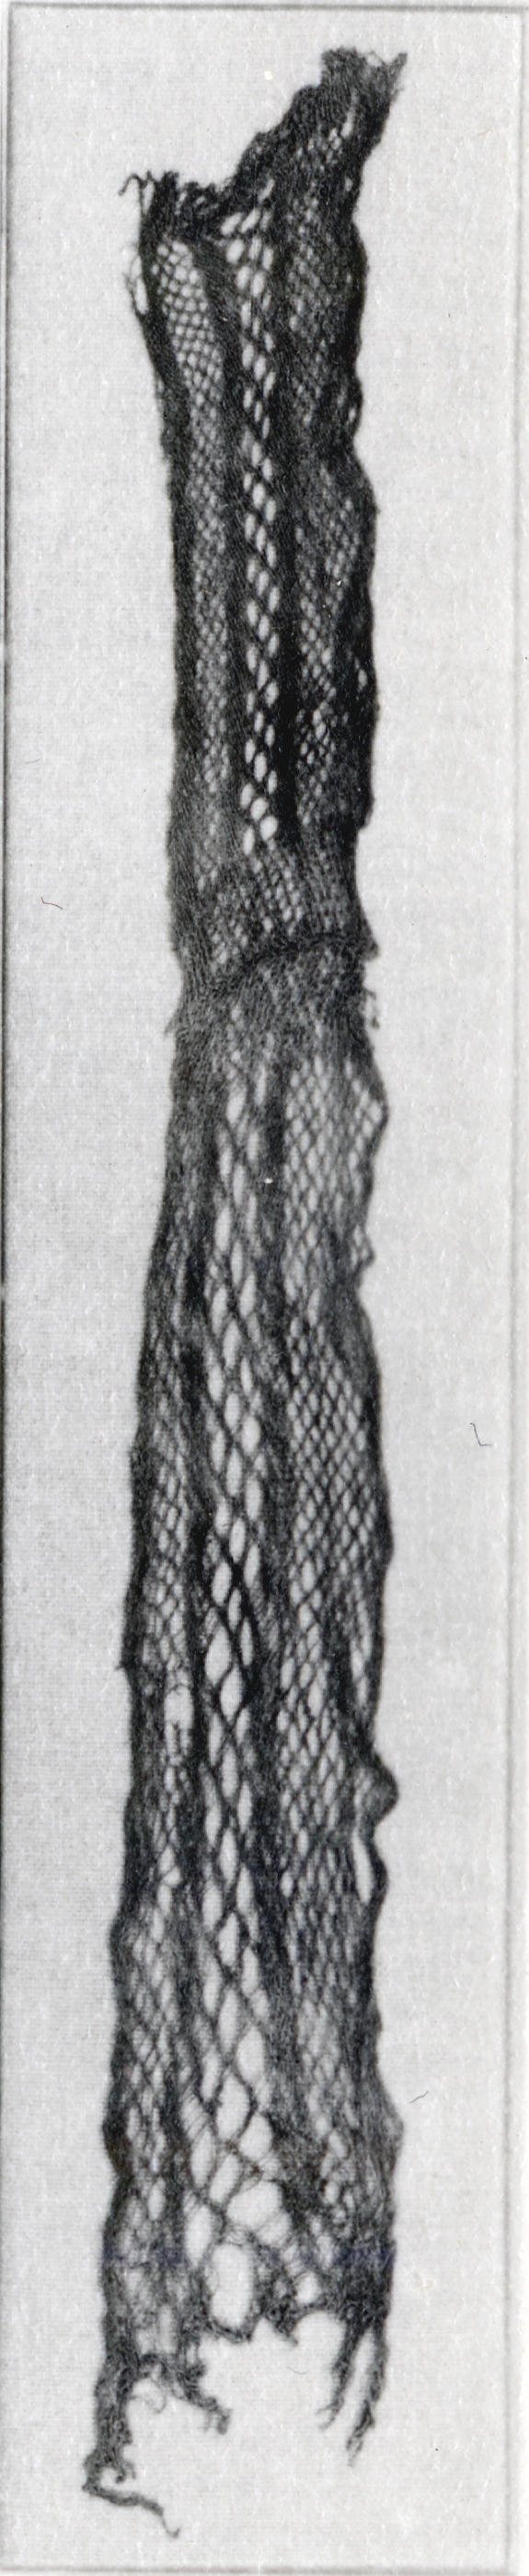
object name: veil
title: Veil (?)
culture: coptic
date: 301-400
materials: linen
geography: egypt